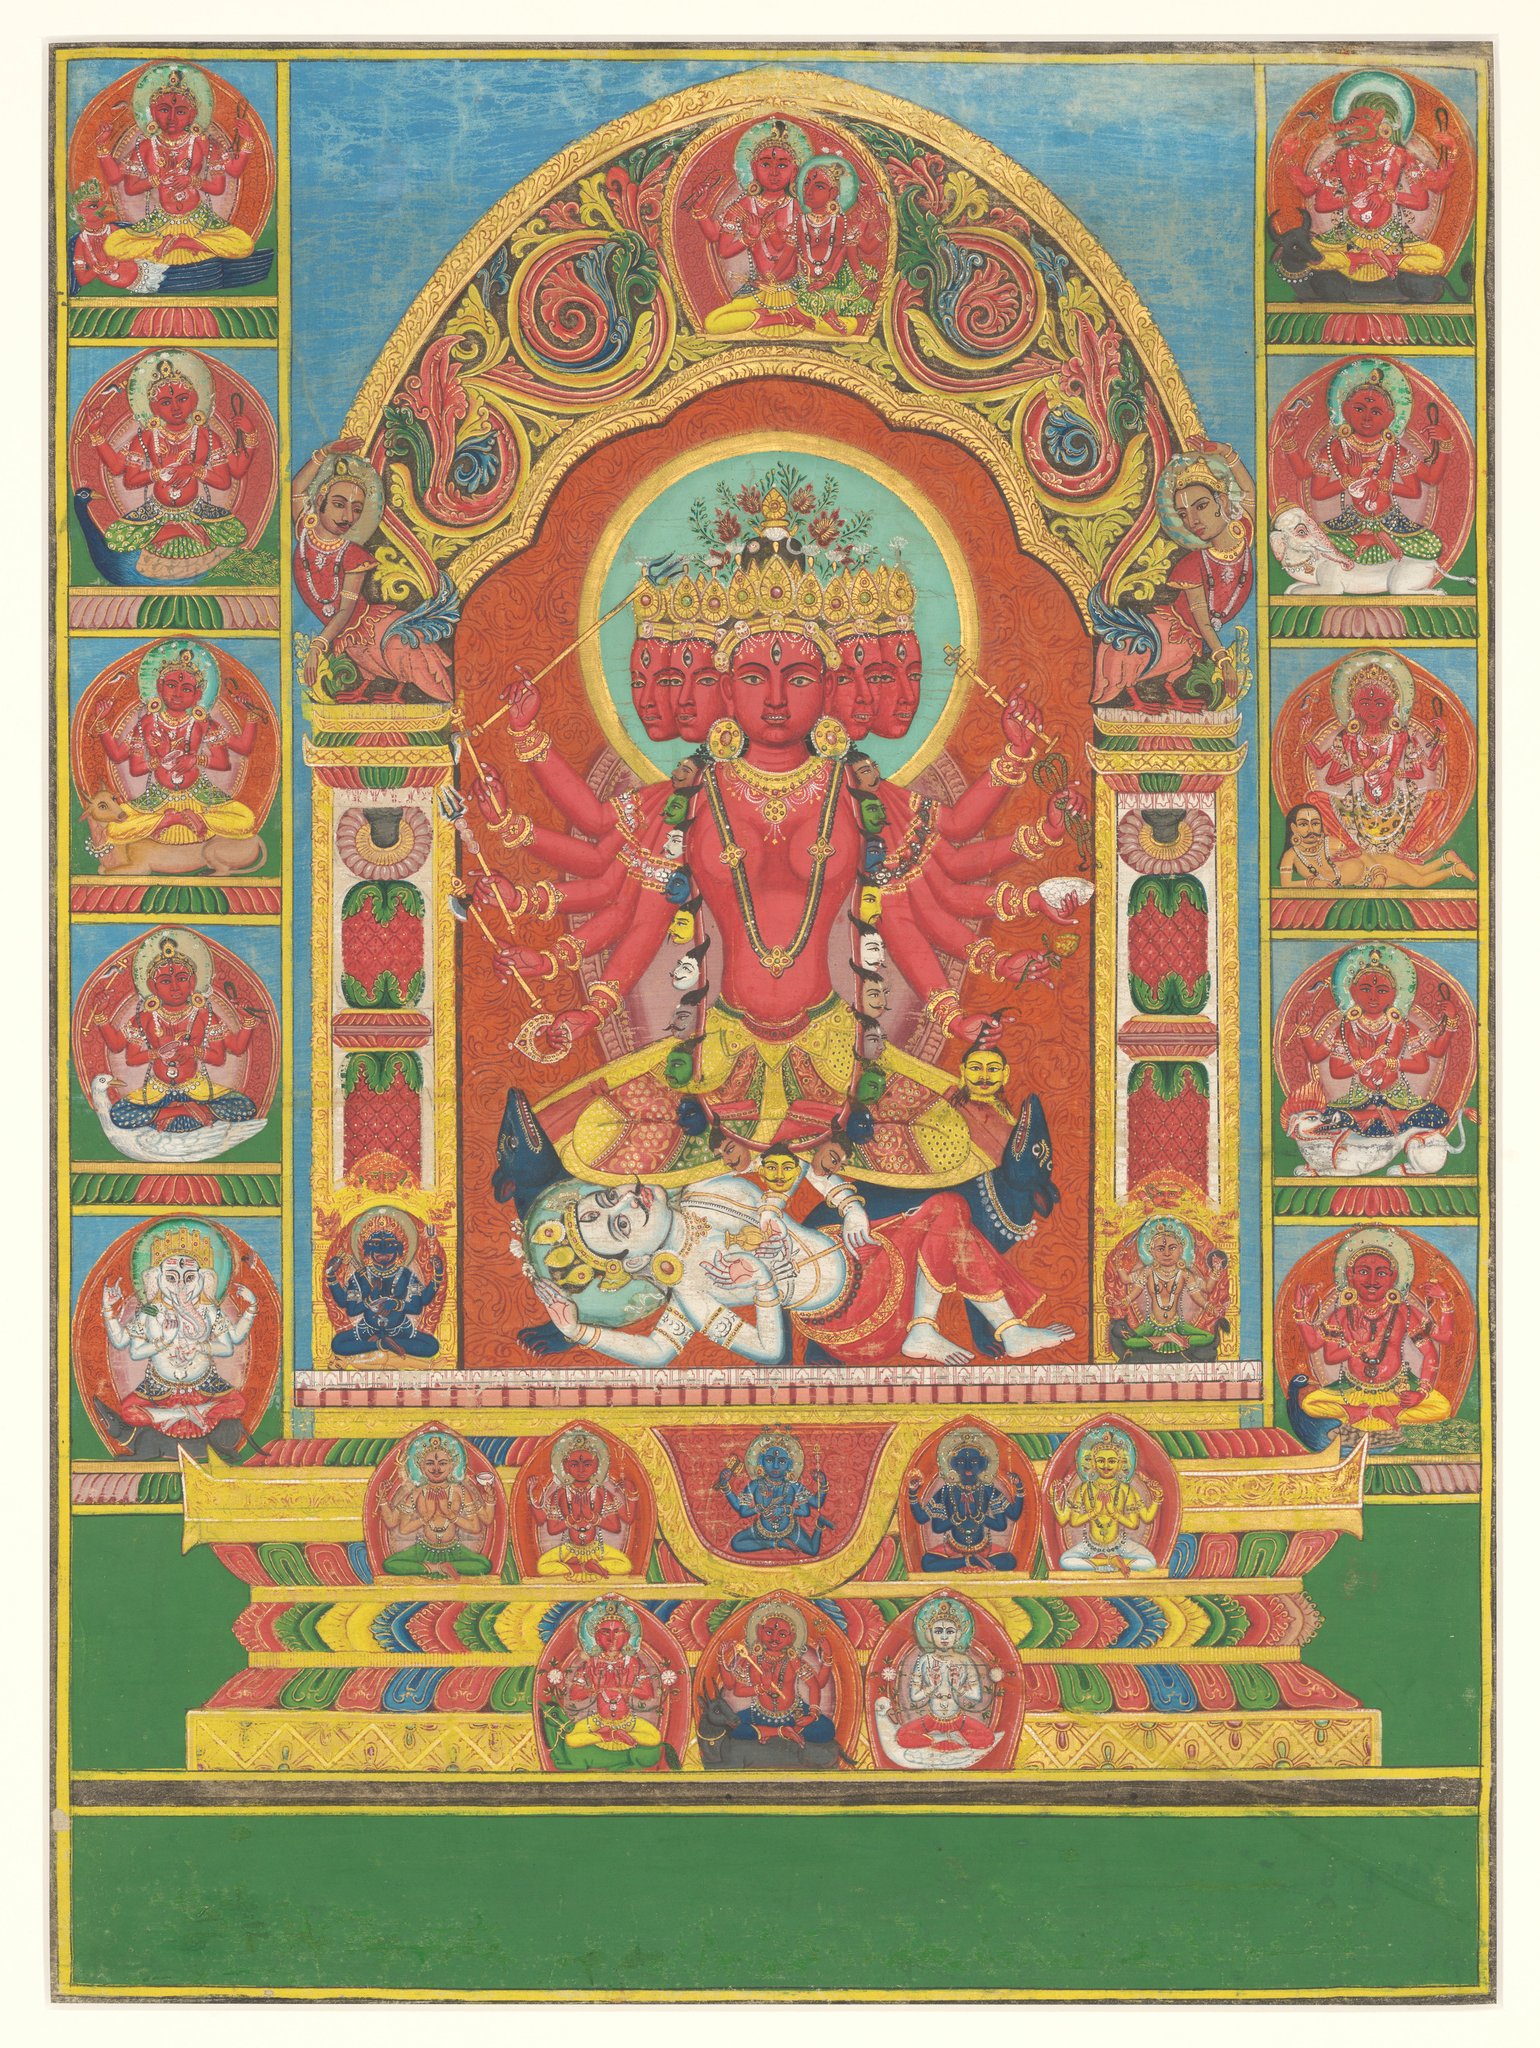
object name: painting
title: Goddess Tripurasundari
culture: nepali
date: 1901-1933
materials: textile, gold